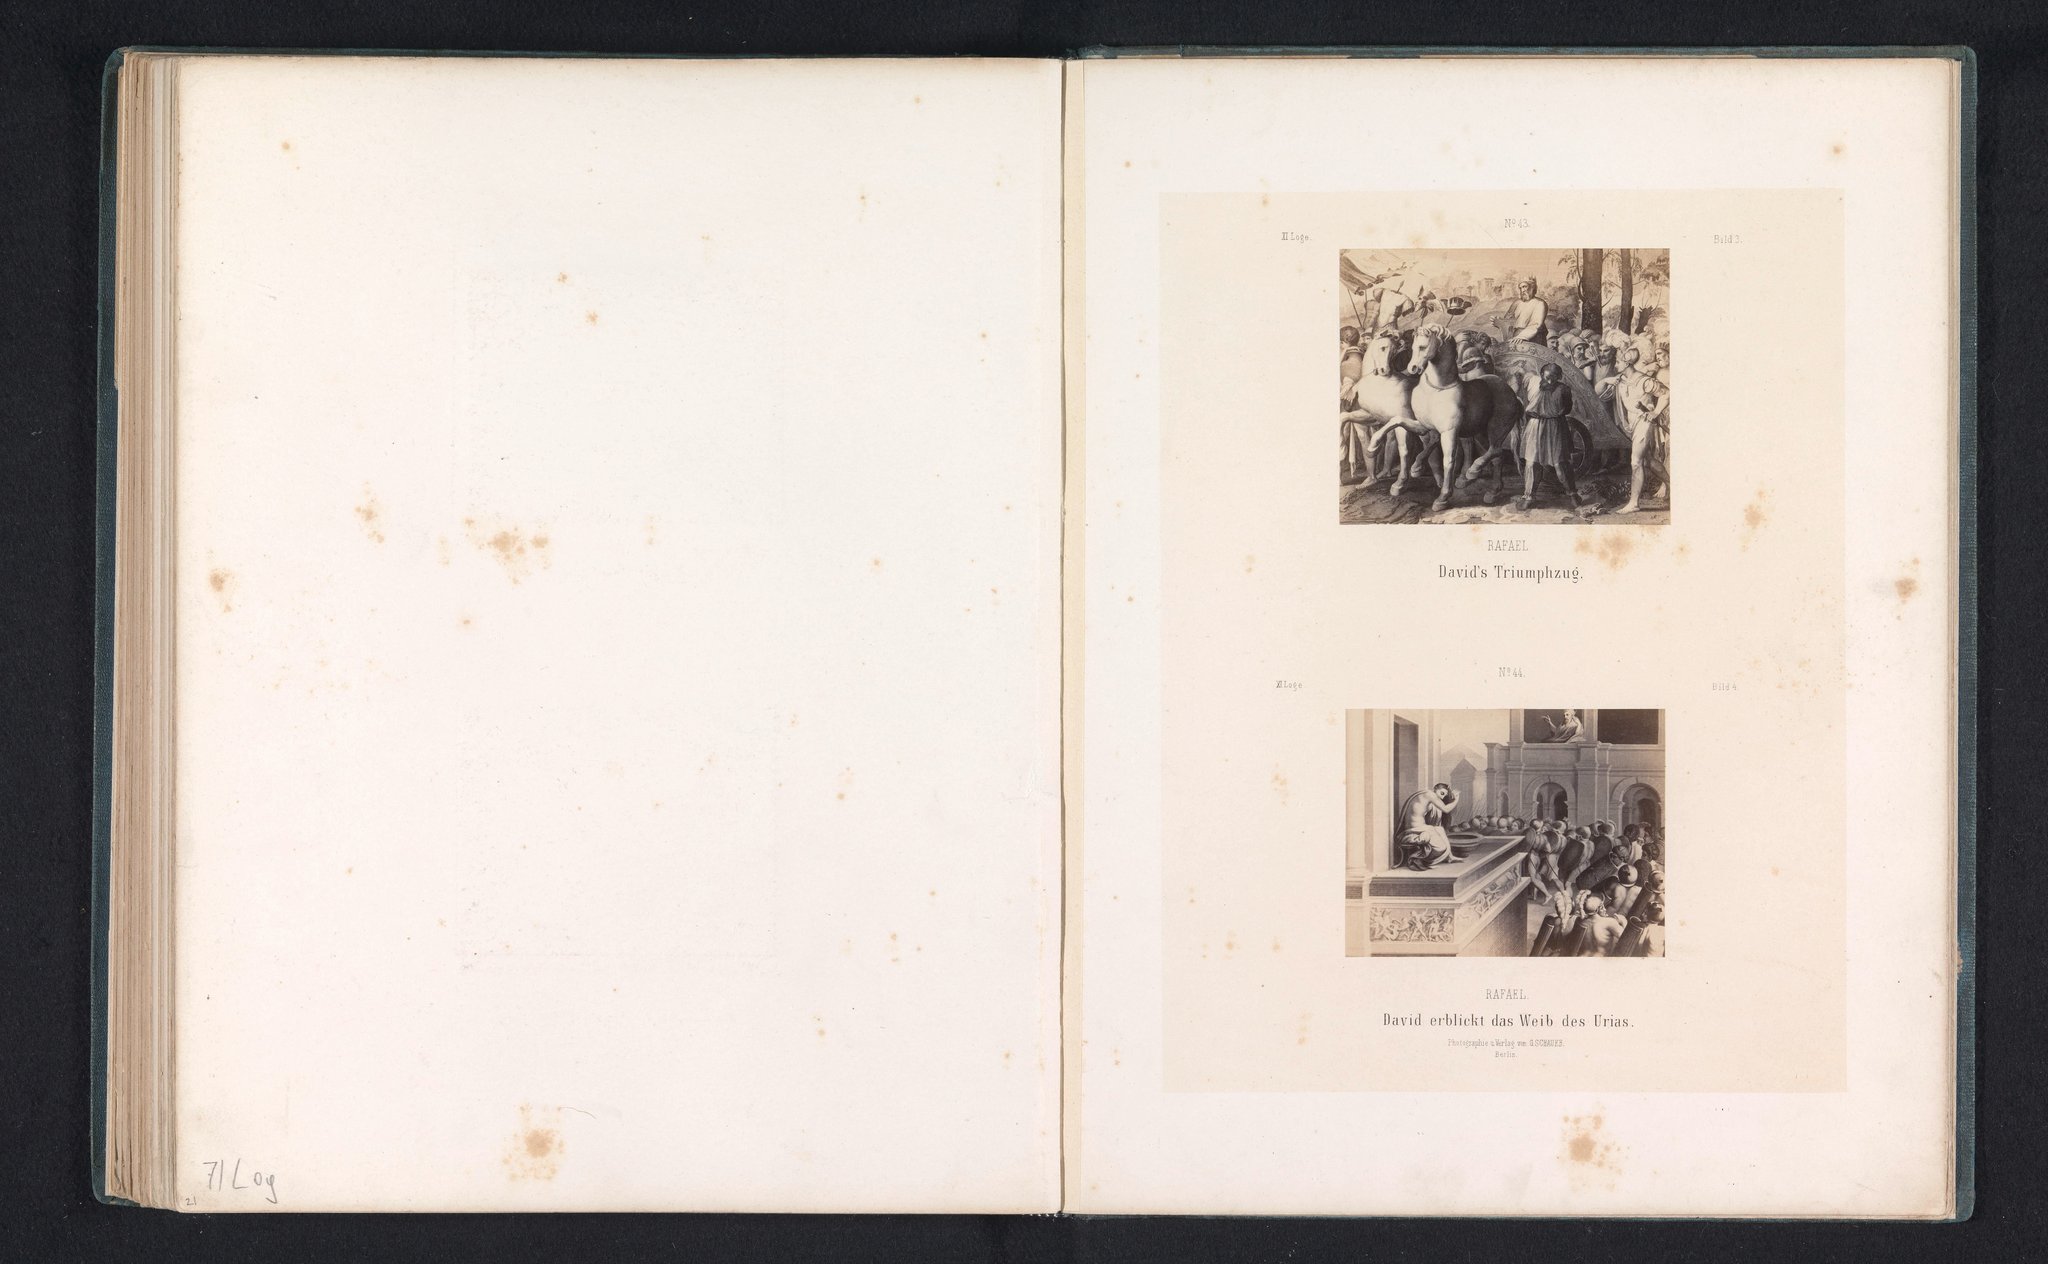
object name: page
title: Fotoreproducties van prenten naar fresco's met voorstellingen van Davids zegetocht en David die Batseba ziet door Rafaël voor de loggia's in het Vaticaan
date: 1851-1861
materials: photographic support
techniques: albumen print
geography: berlin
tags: david's triumph: the women of israel come out to welcome david, singing, dancing, and playing tambourines and lyres; david holding the head of goliath, david, from the roof (or balcony) of his palace, sees bathsheba bathing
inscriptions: number: ‘No 43. No 44. Bild 3. Bild 4. XI. Loge.’